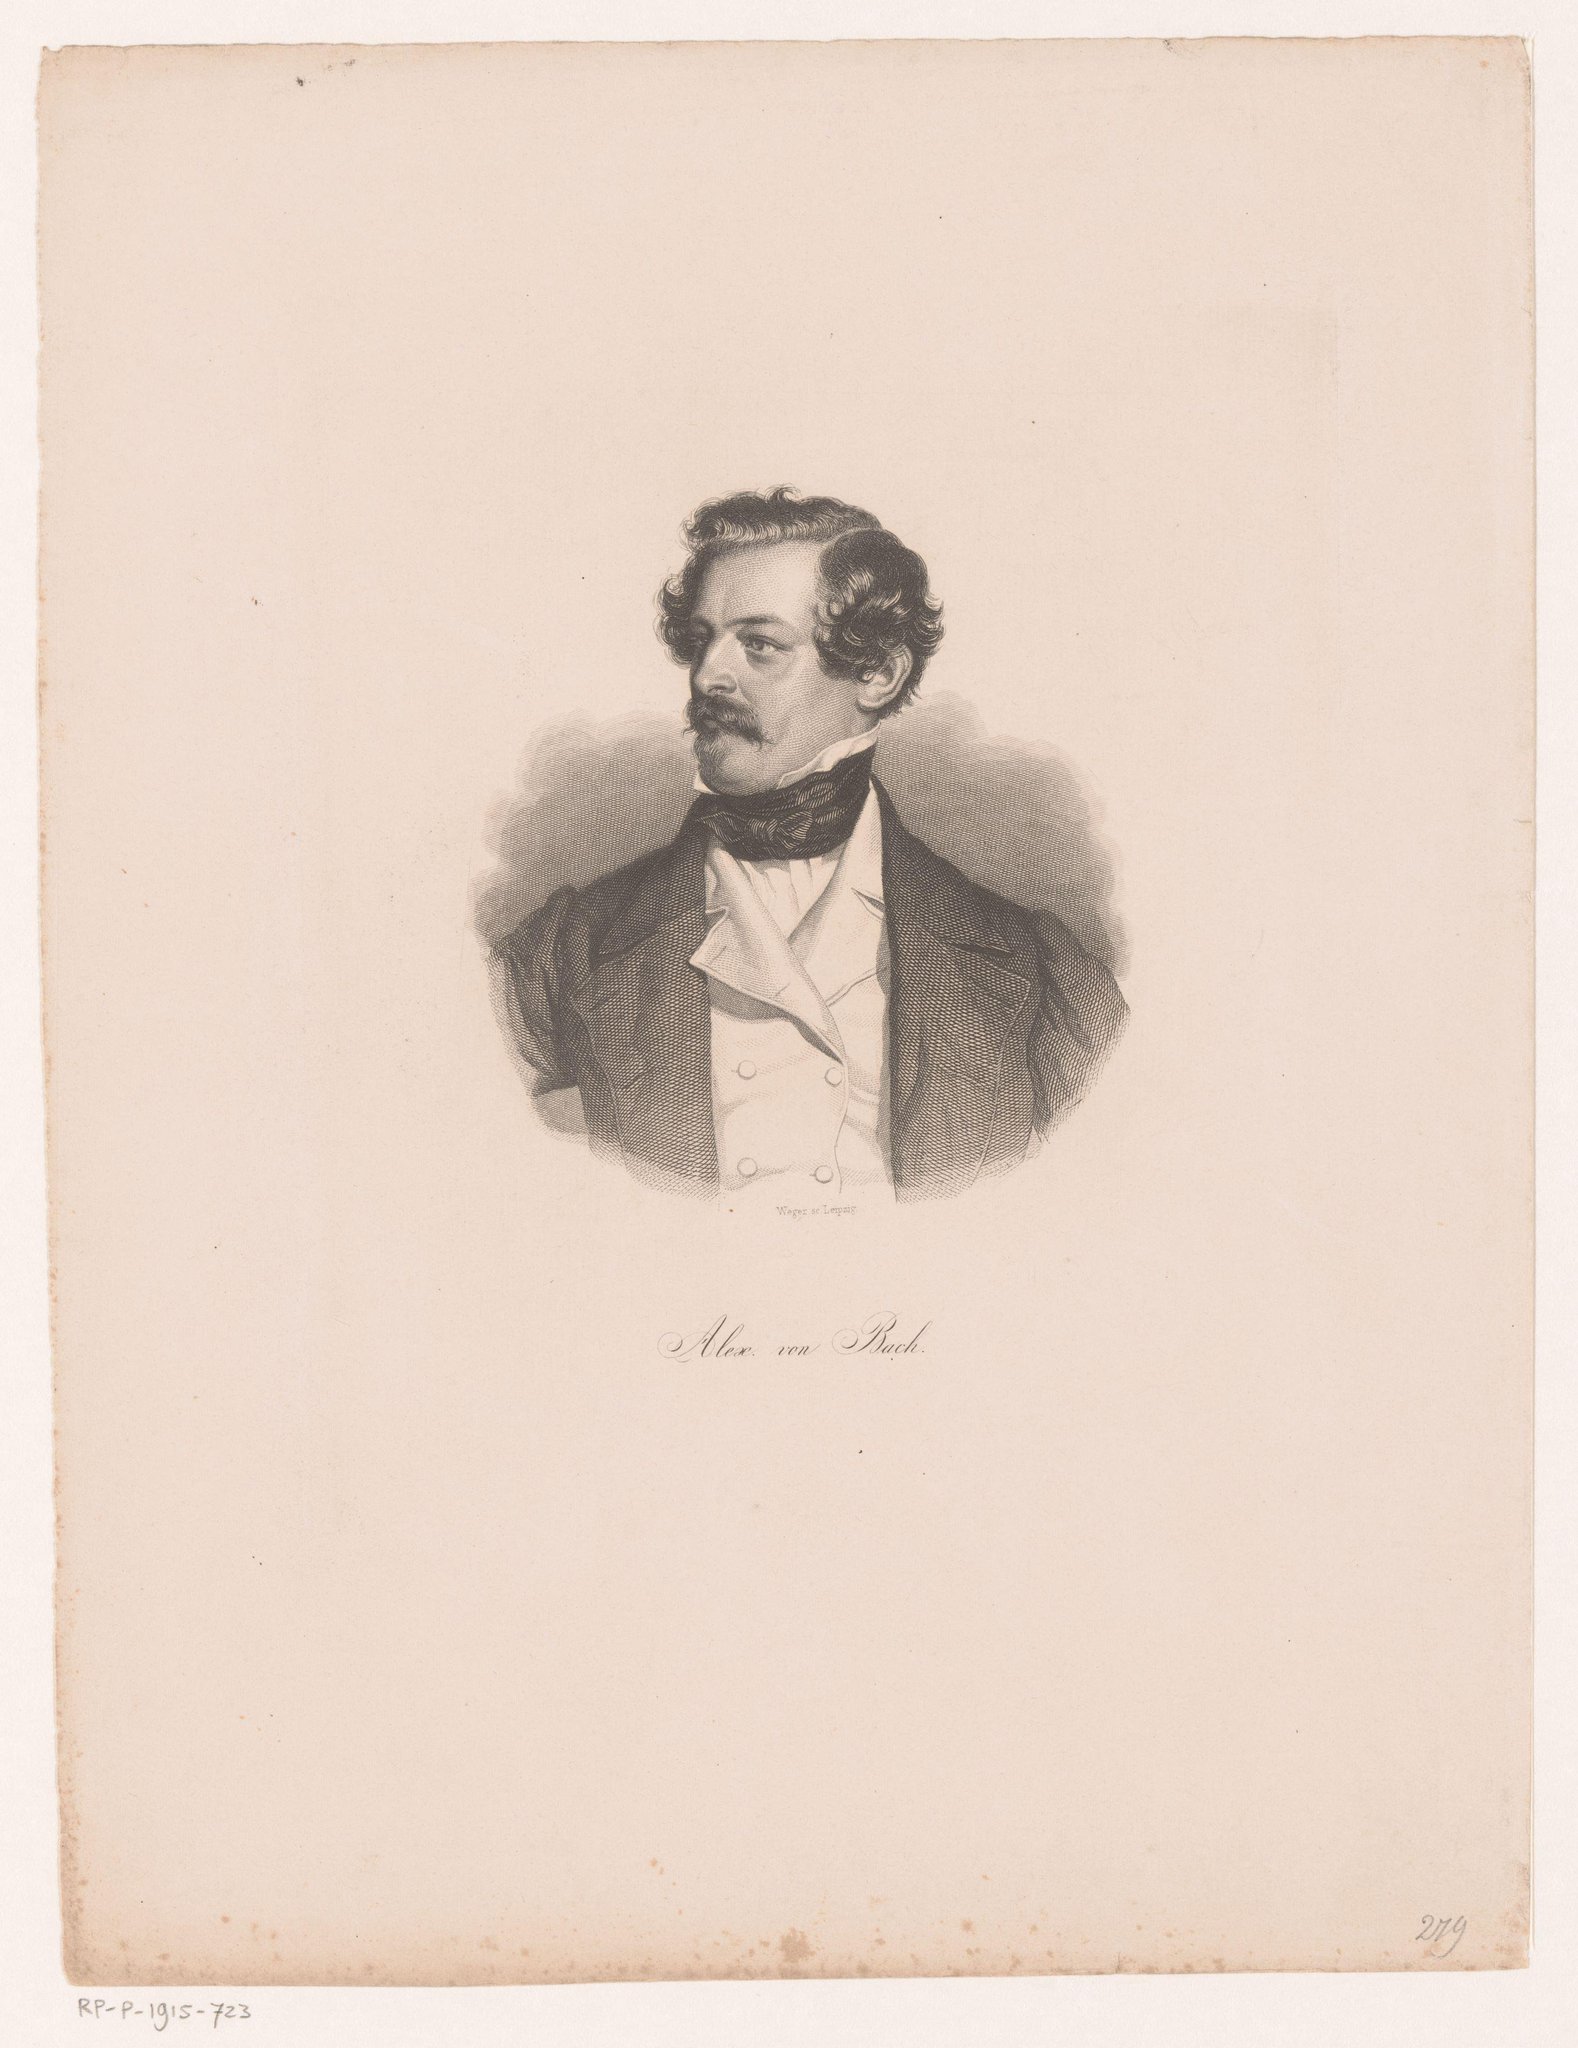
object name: print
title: Portret van Alexander Freiherr von Bach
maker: august weger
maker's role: print maker, printer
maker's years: 1823-1892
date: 1849-1892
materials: paper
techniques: engraving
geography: leipzig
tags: historical persons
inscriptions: collector's mark: Lugt 2228